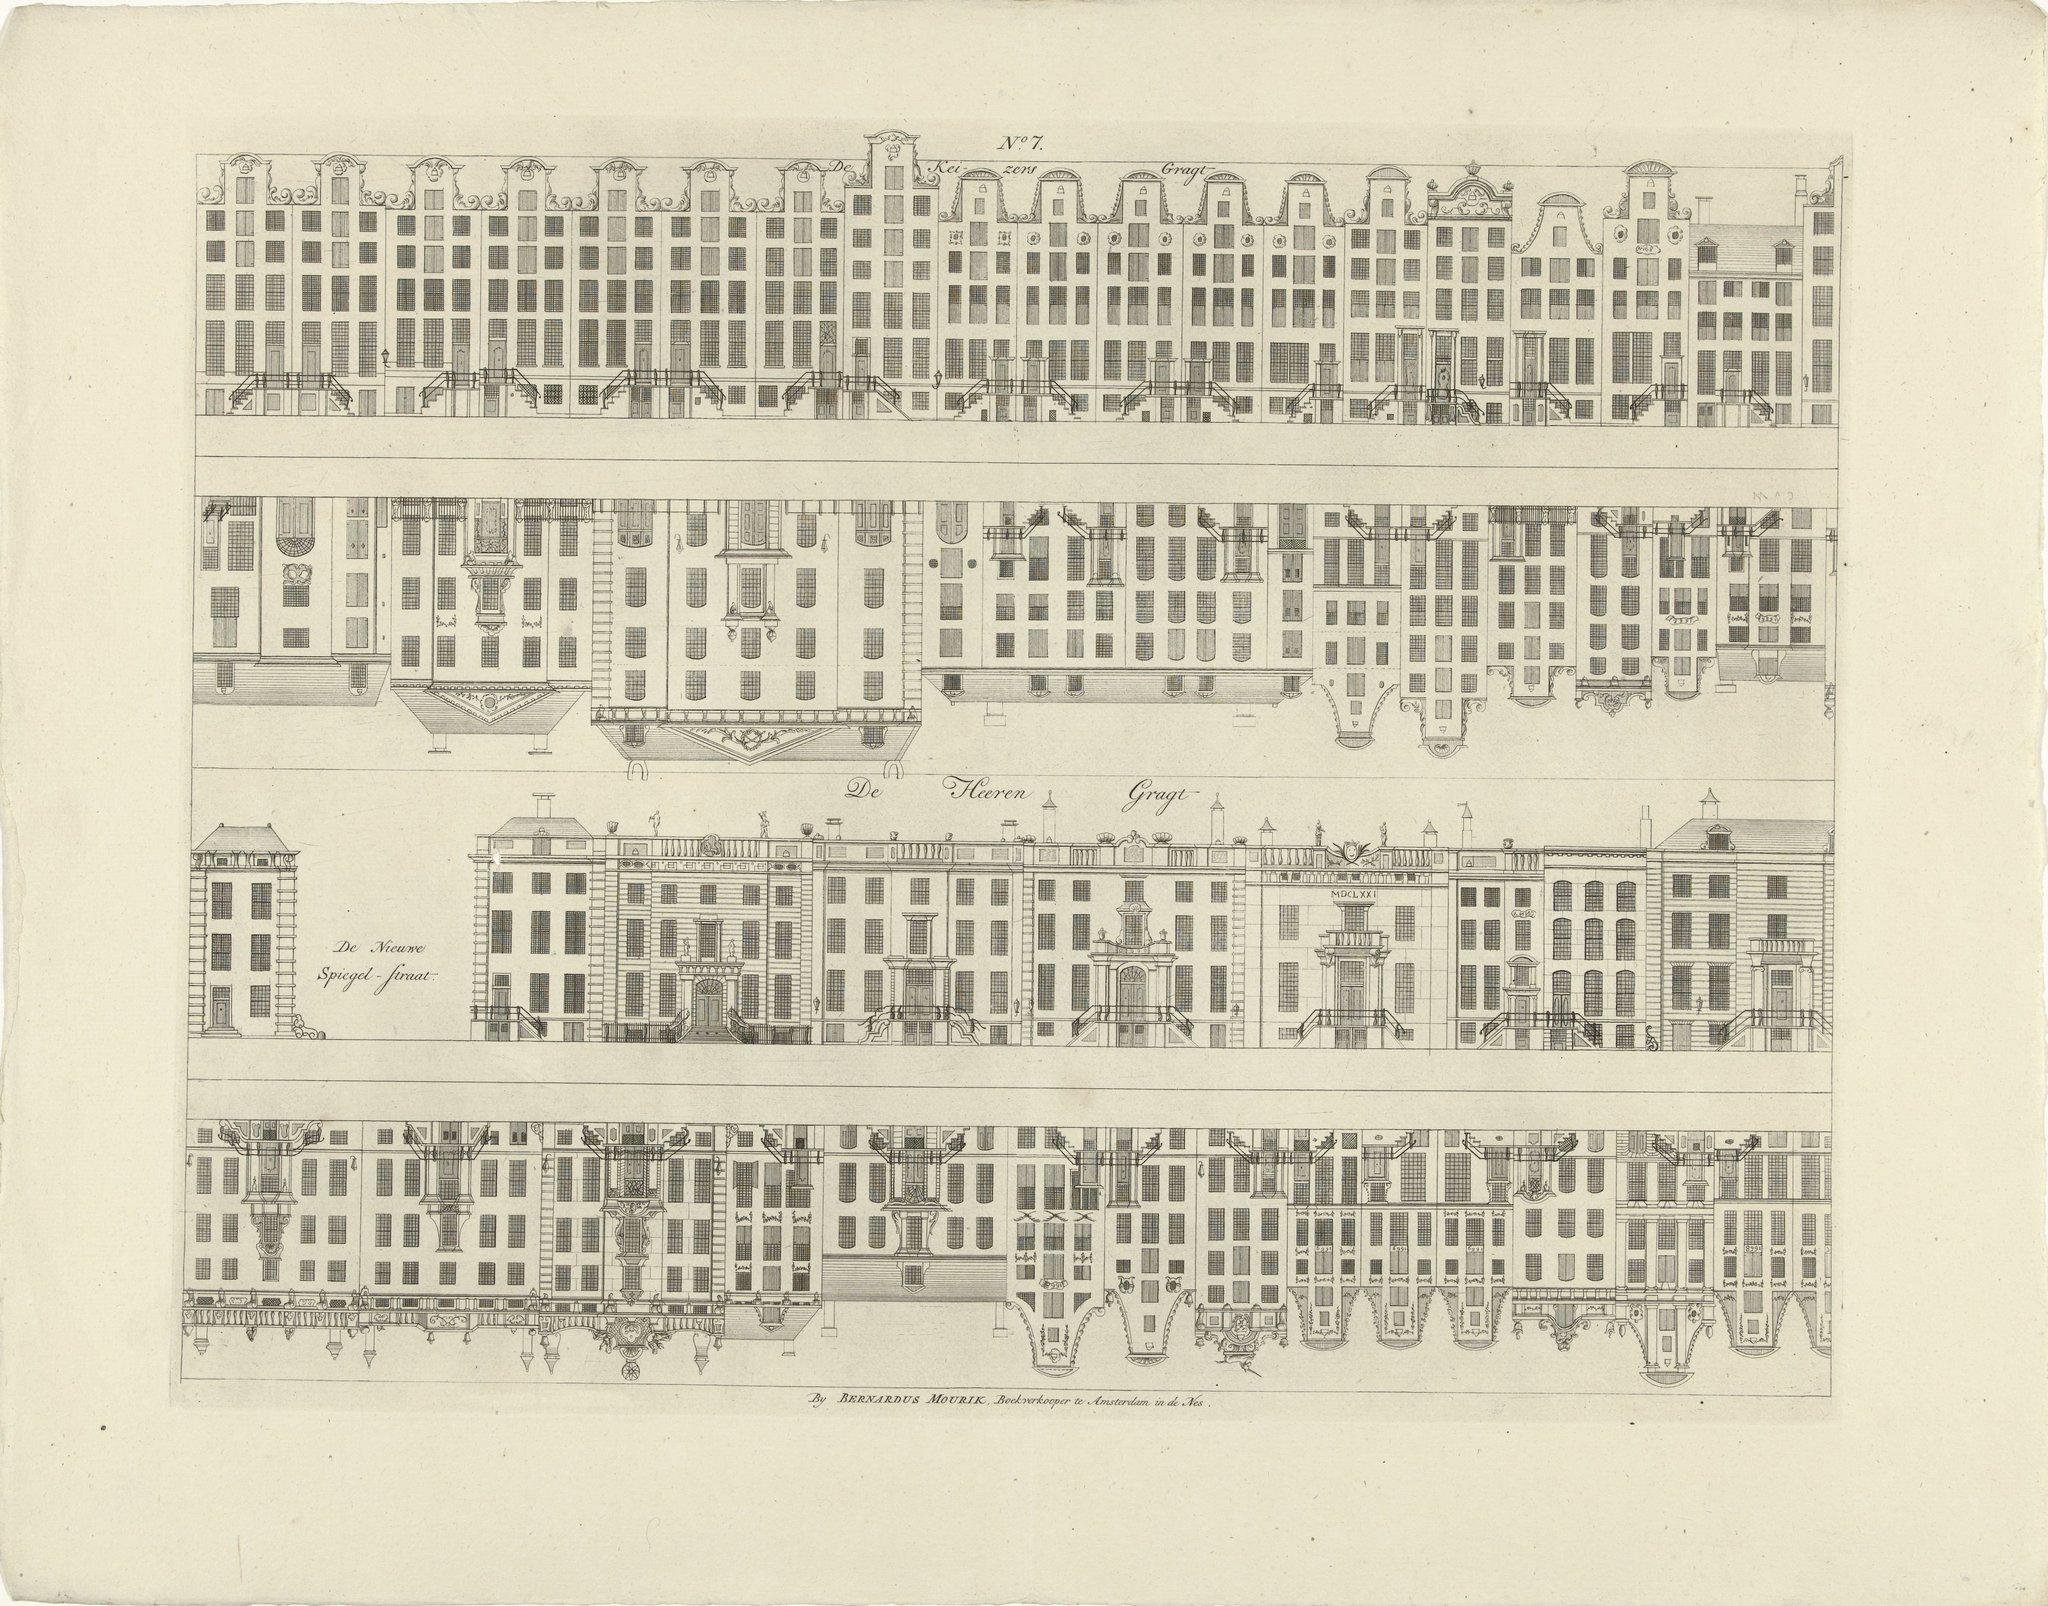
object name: print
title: Gevels van huizenrijen aan de Keizersgracht en de Herengracht naar de Nieuwe Spiegelstraat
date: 1768-1771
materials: paper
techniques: etching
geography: amsterdam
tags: front façade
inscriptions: collector's mark: Lugt 2233, collector's mark: Lugt 2228